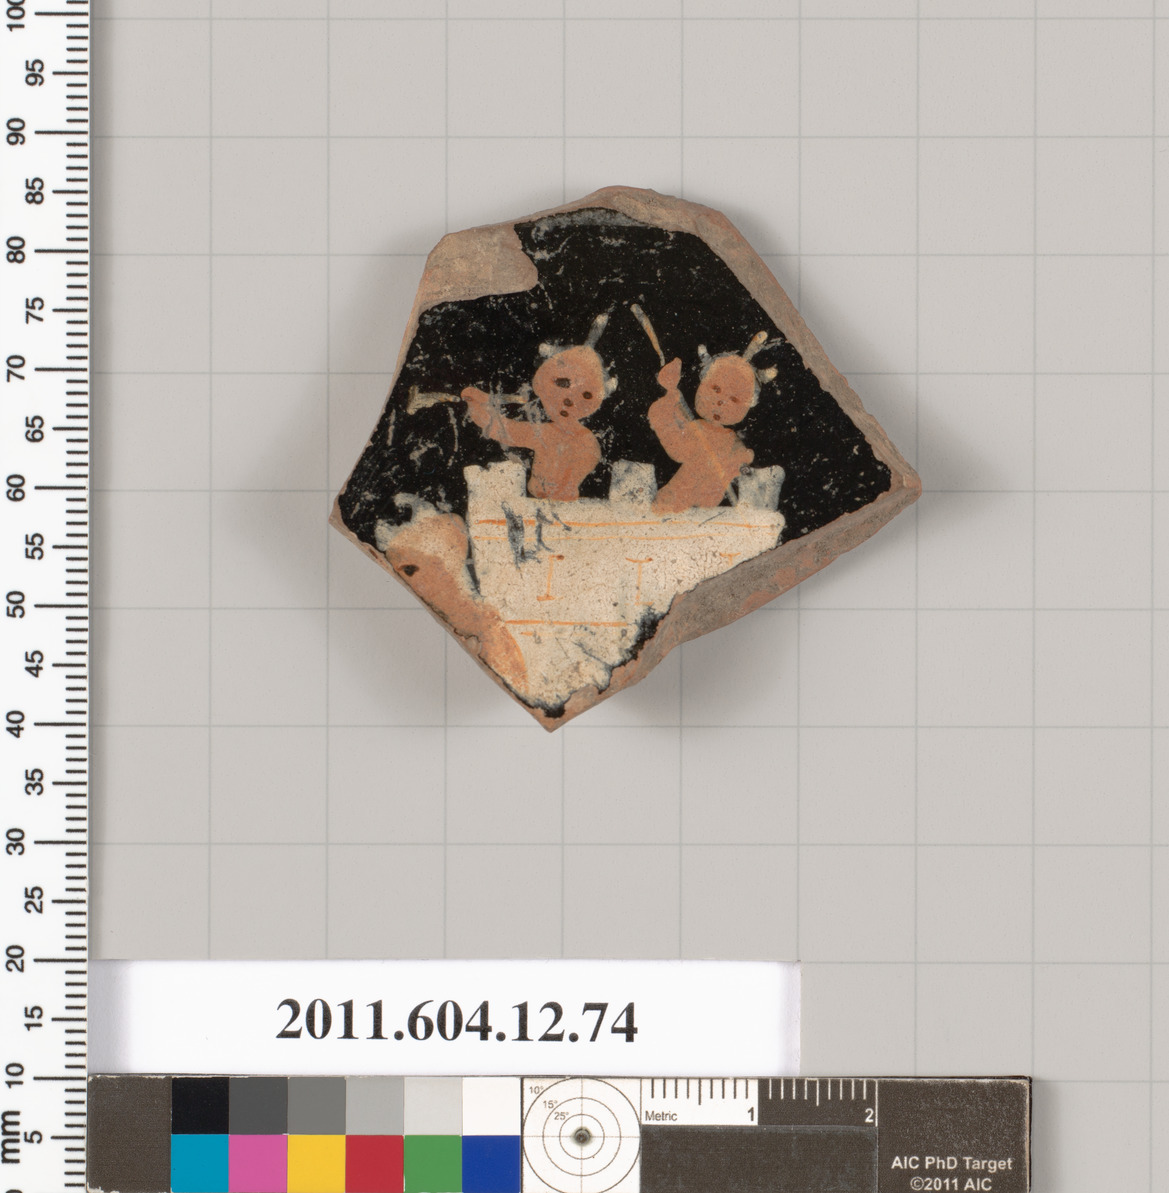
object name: kylix fragment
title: Terracotta fragment of a kylix (drinking cup)?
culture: greek or south italian or campanian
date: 400-301 BCE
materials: terracotta